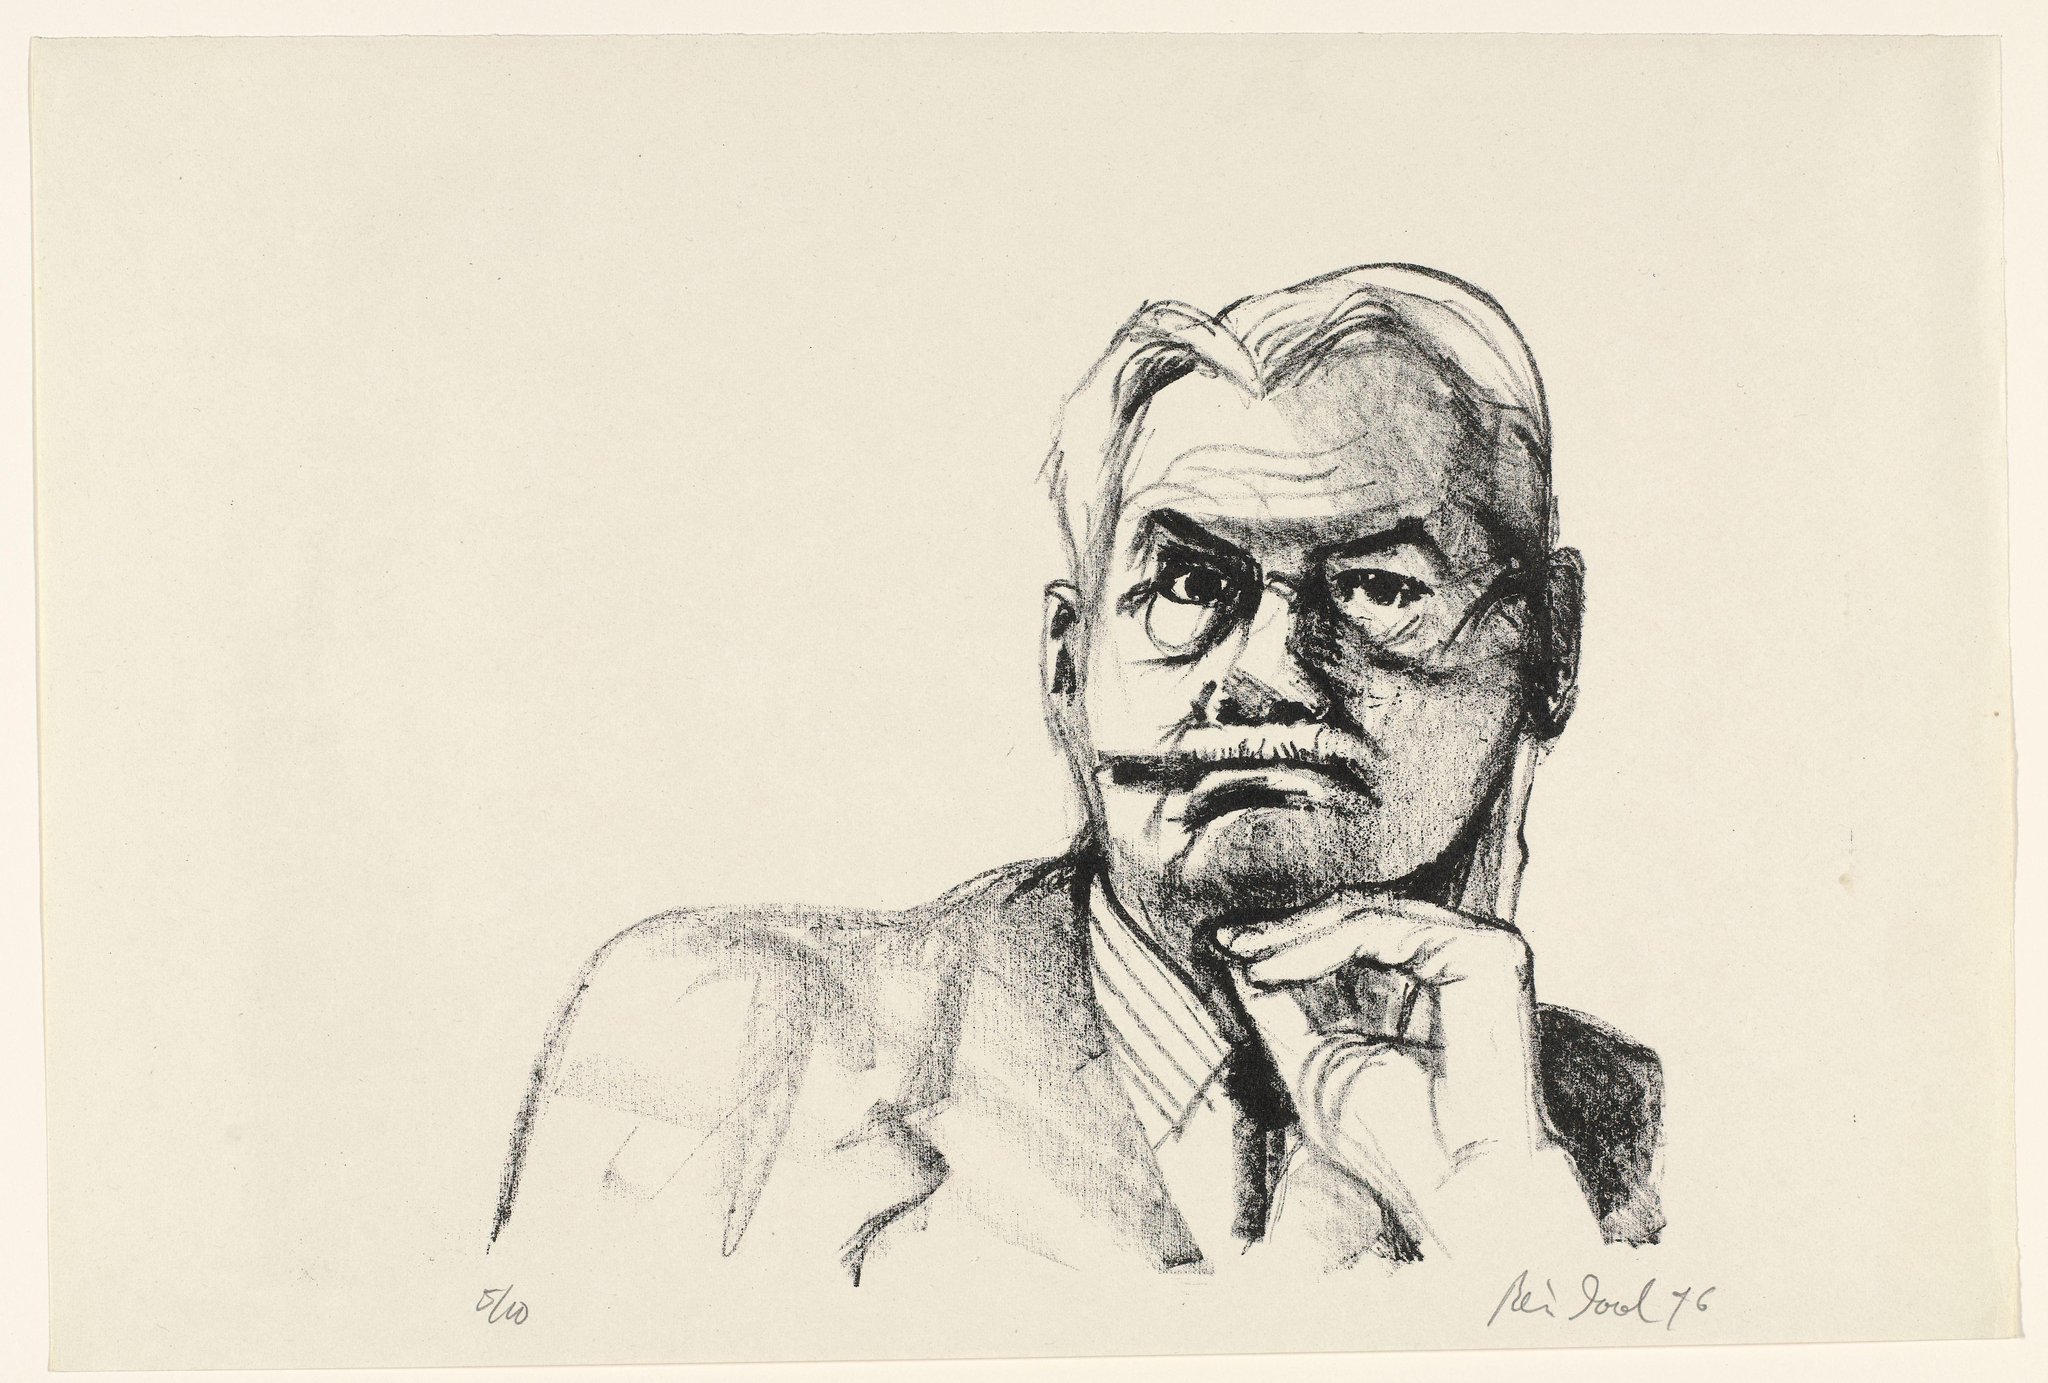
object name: print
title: Bestuurscollege Rijksuniversiteit Leiden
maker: rein dool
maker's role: draughtsman, painter, print maker, sculptor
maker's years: 1933-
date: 1976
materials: paper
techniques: lithograph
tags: universiteit van leiden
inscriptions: edition: ‘5/10’, signature and date: ‘Rein Dool 76’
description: Portret van Nanne Fokke Hofstee, secretaris van het College van Bestuur van de Rijksuniversiteit Leiden.